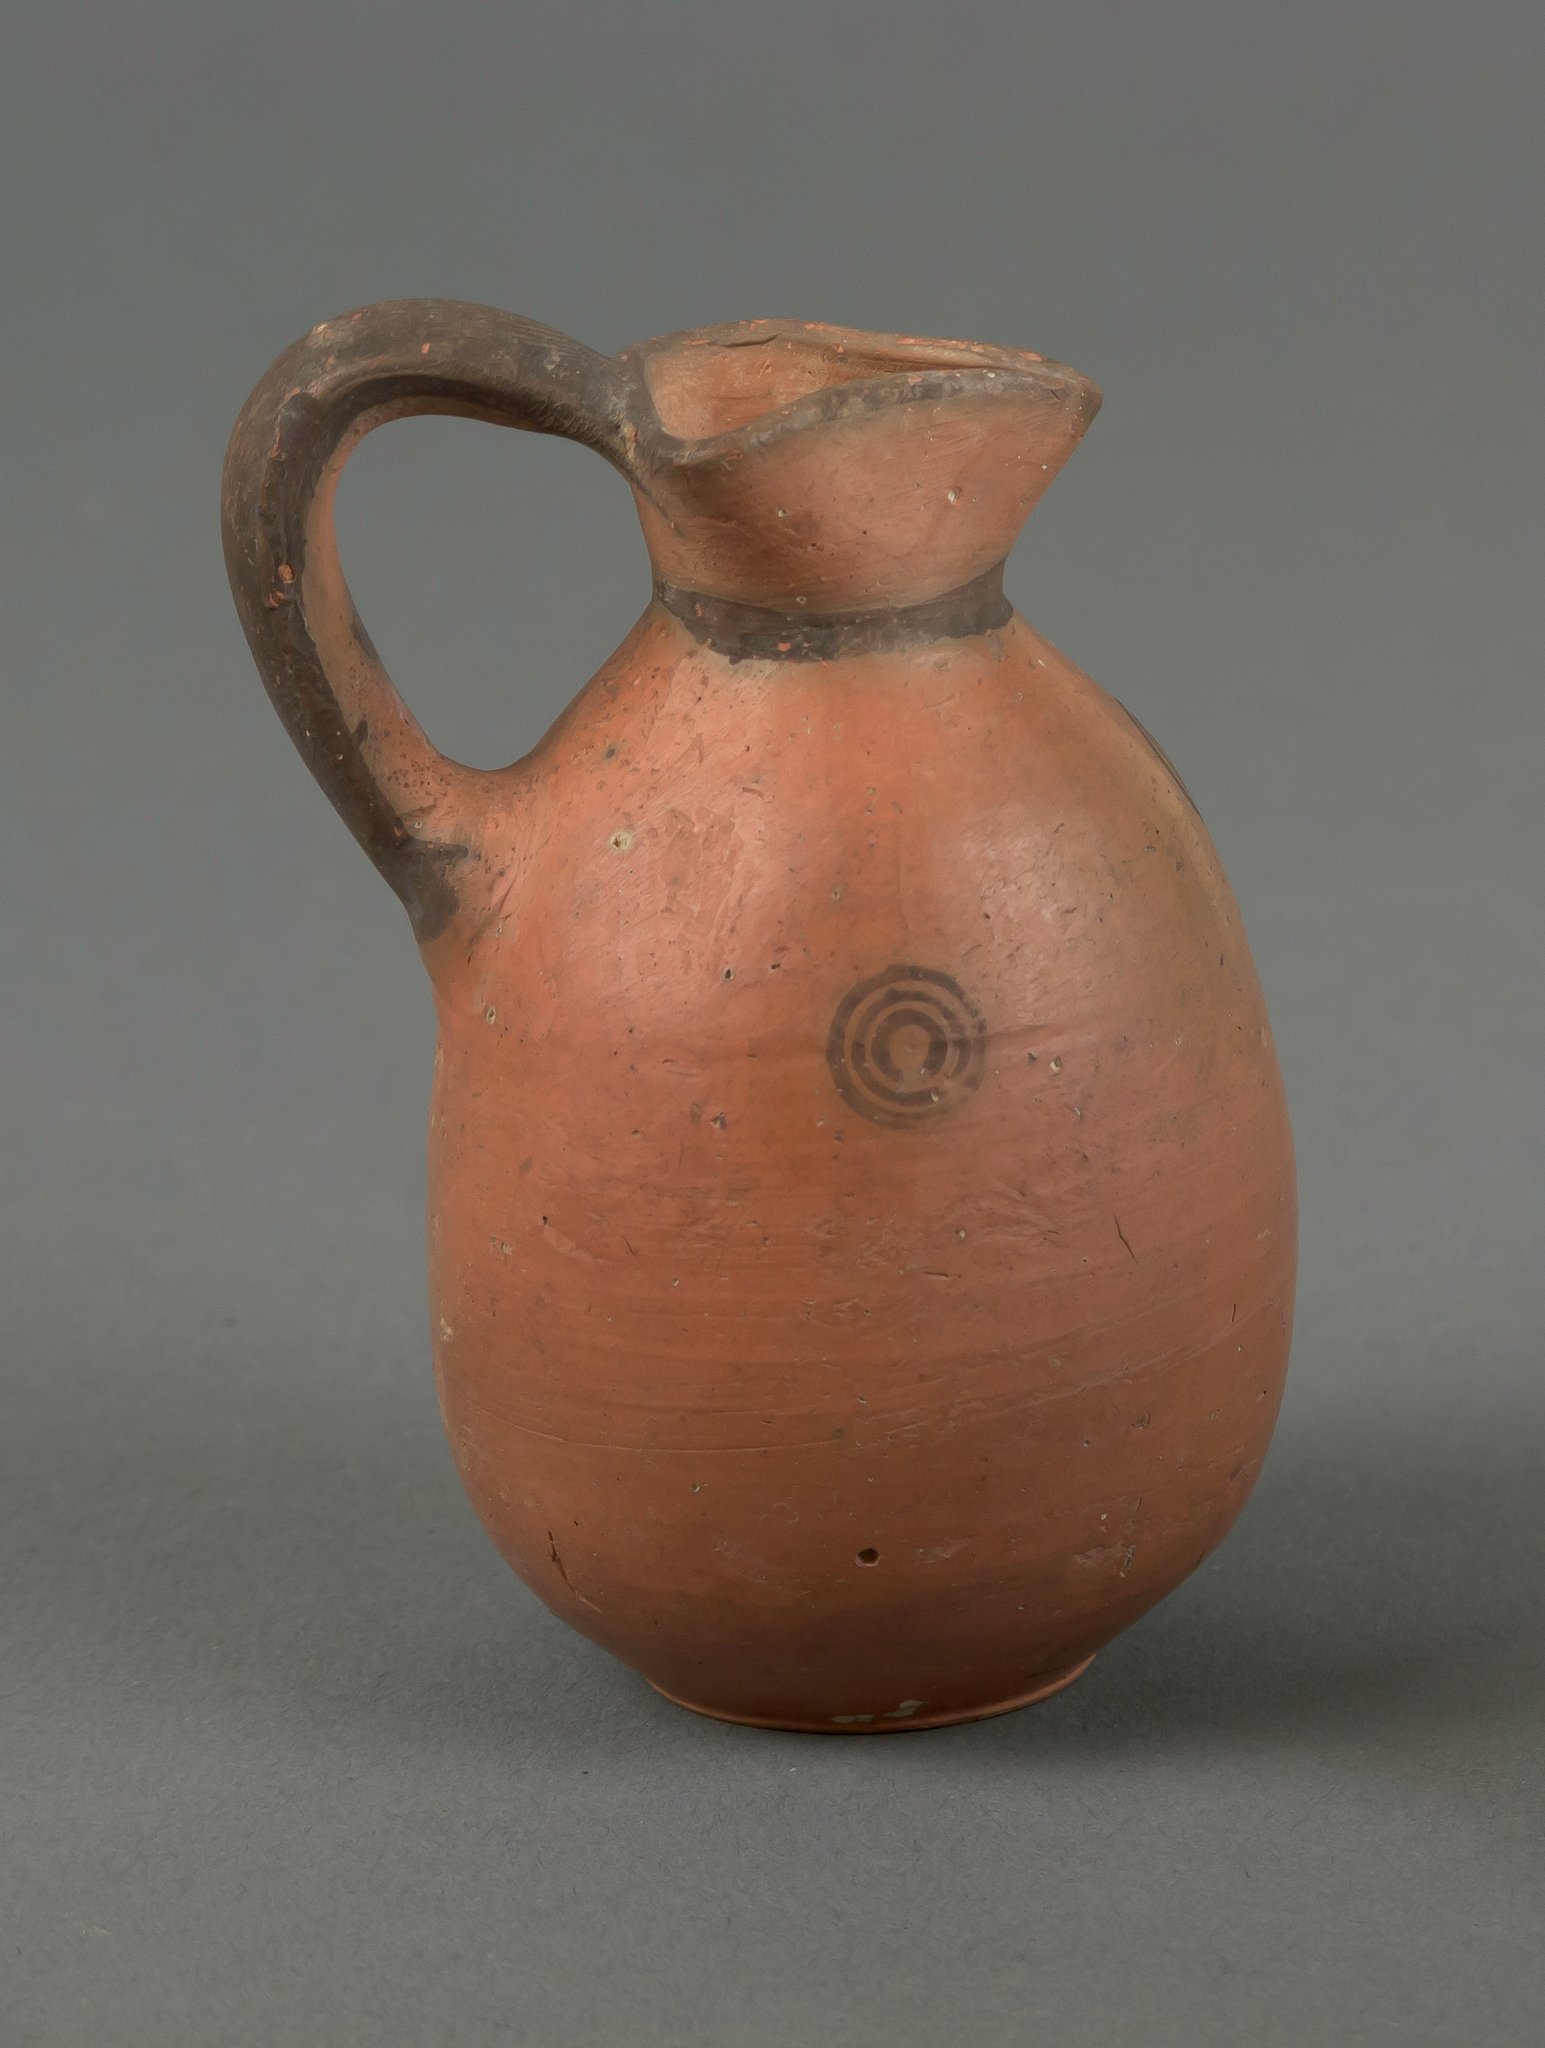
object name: juglet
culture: cypriot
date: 750-600 BCE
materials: terracotta